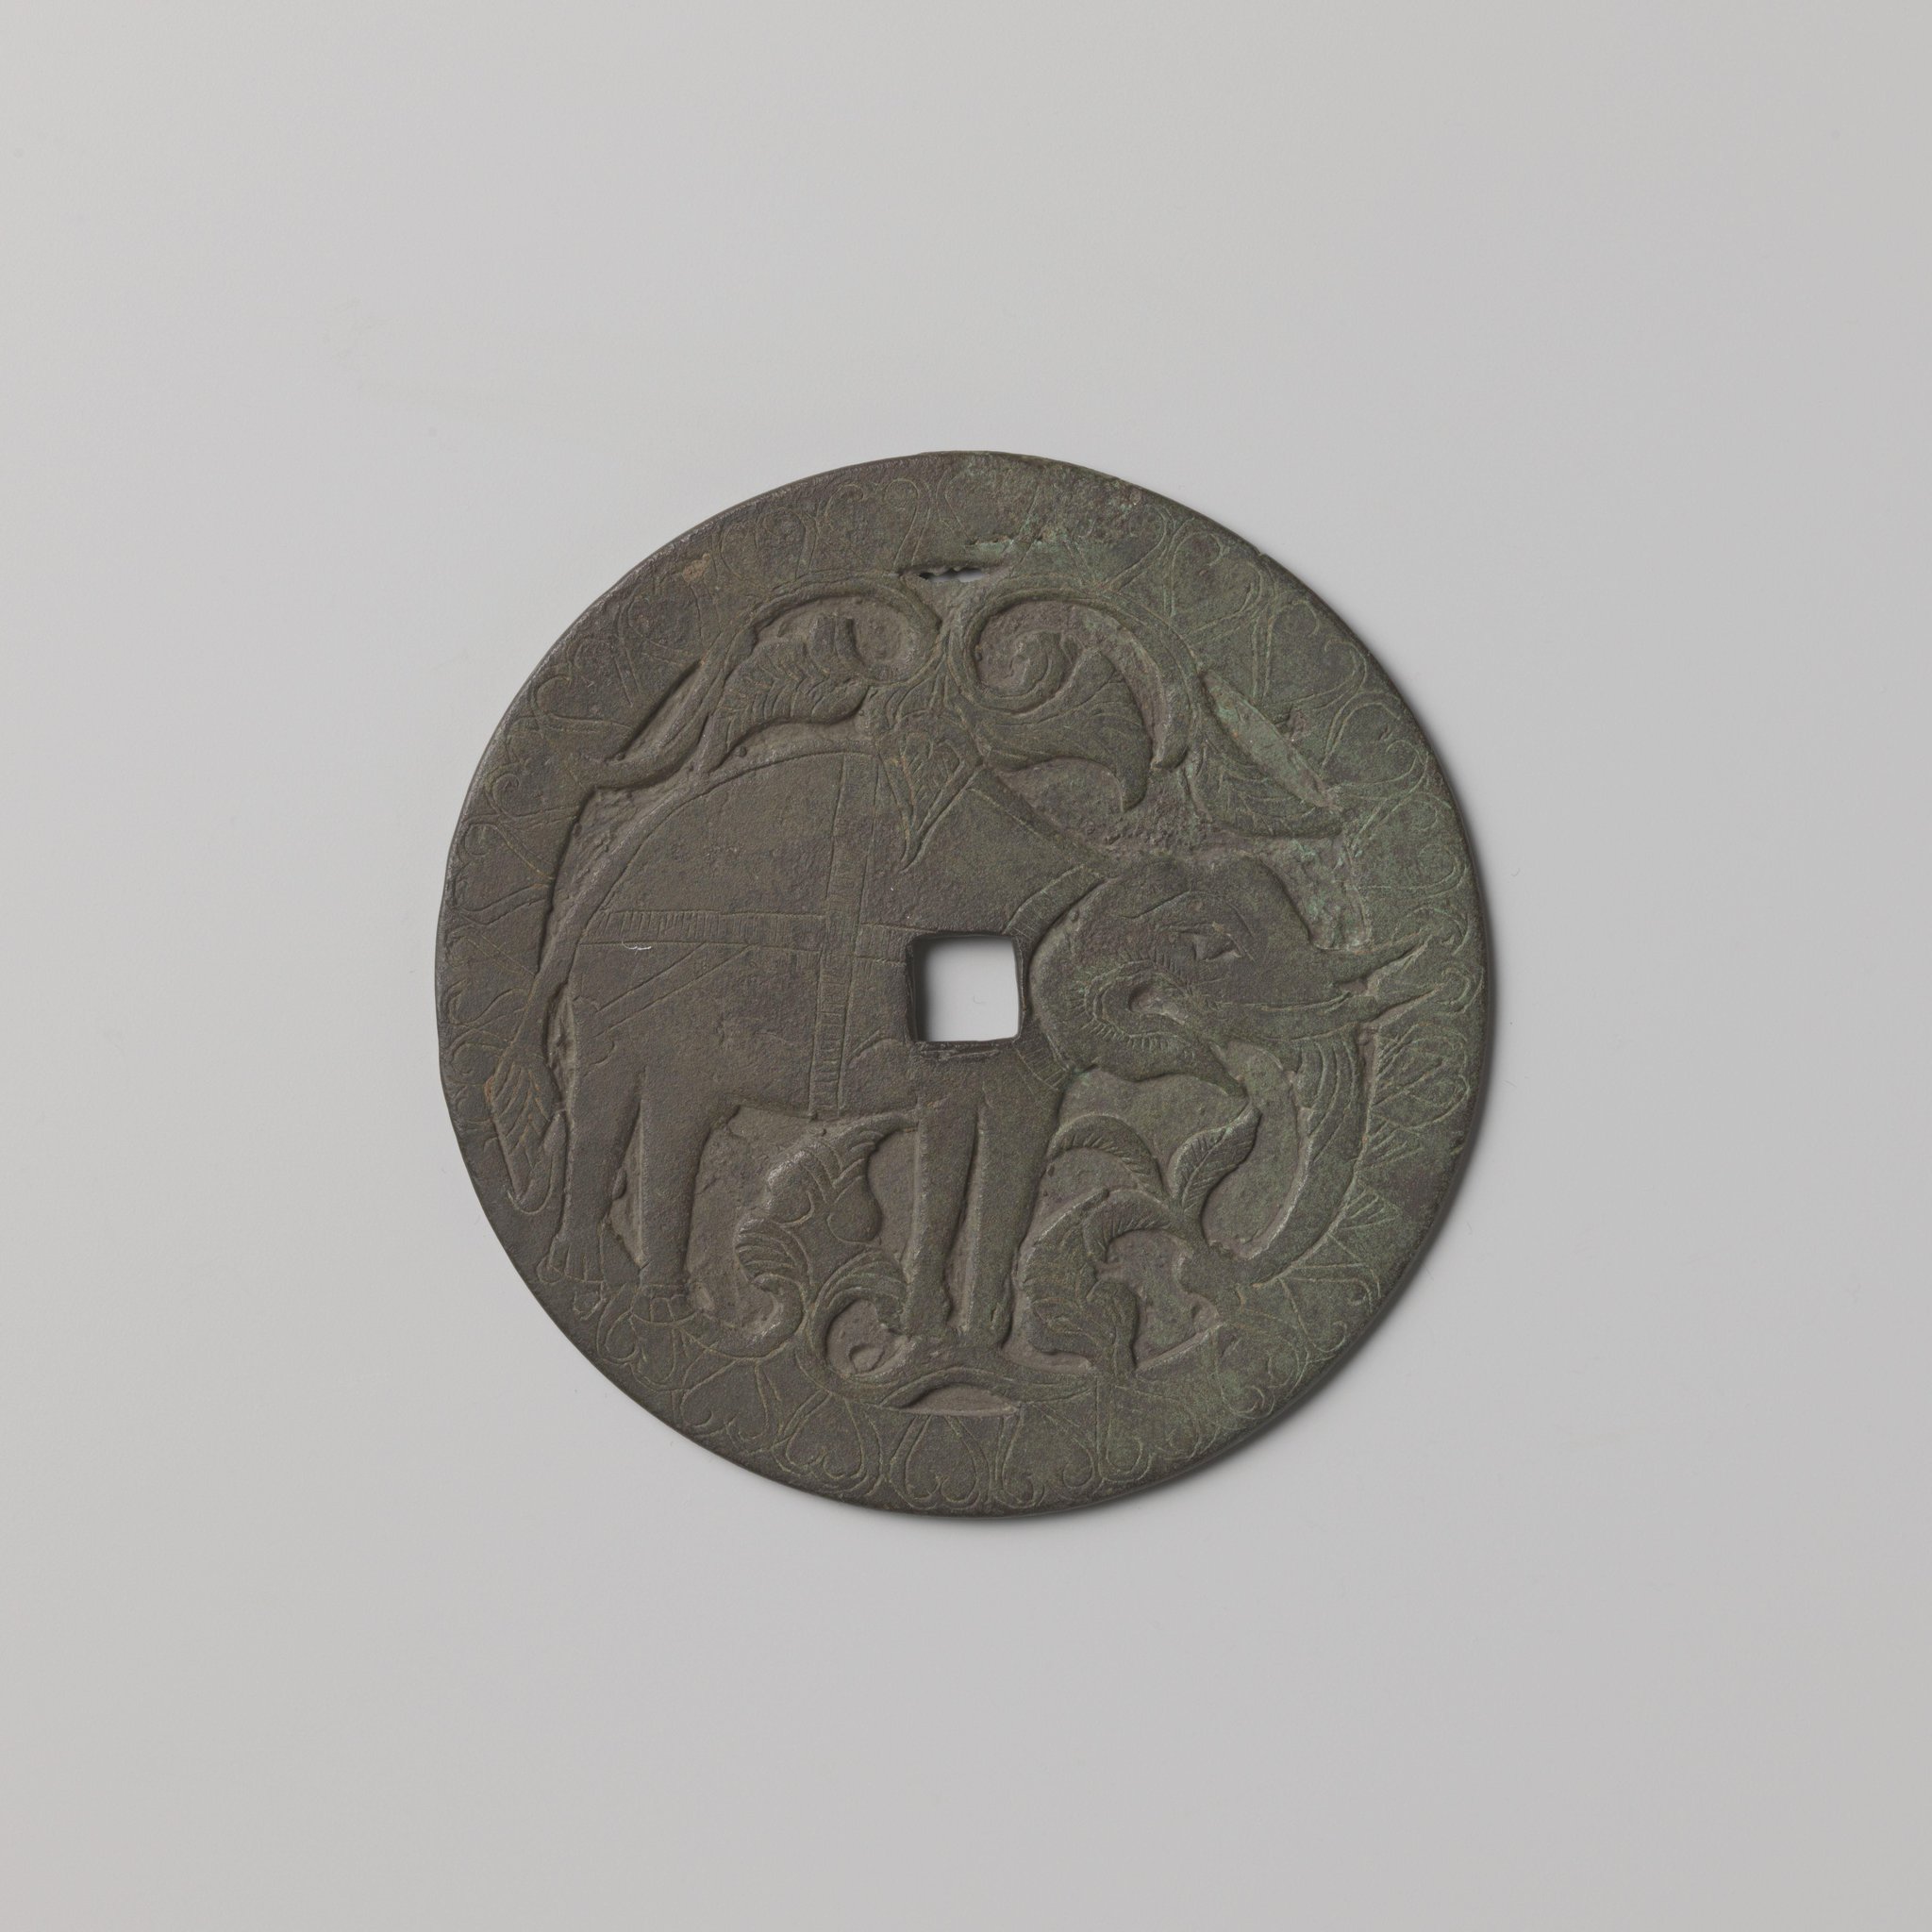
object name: plate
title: Plaat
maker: Anonymous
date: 1300-1600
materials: bronze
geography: indonesia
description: Plaat (ronde), brons, brede geornamenteerde rand, daarbinnen in reliëf een olifant .